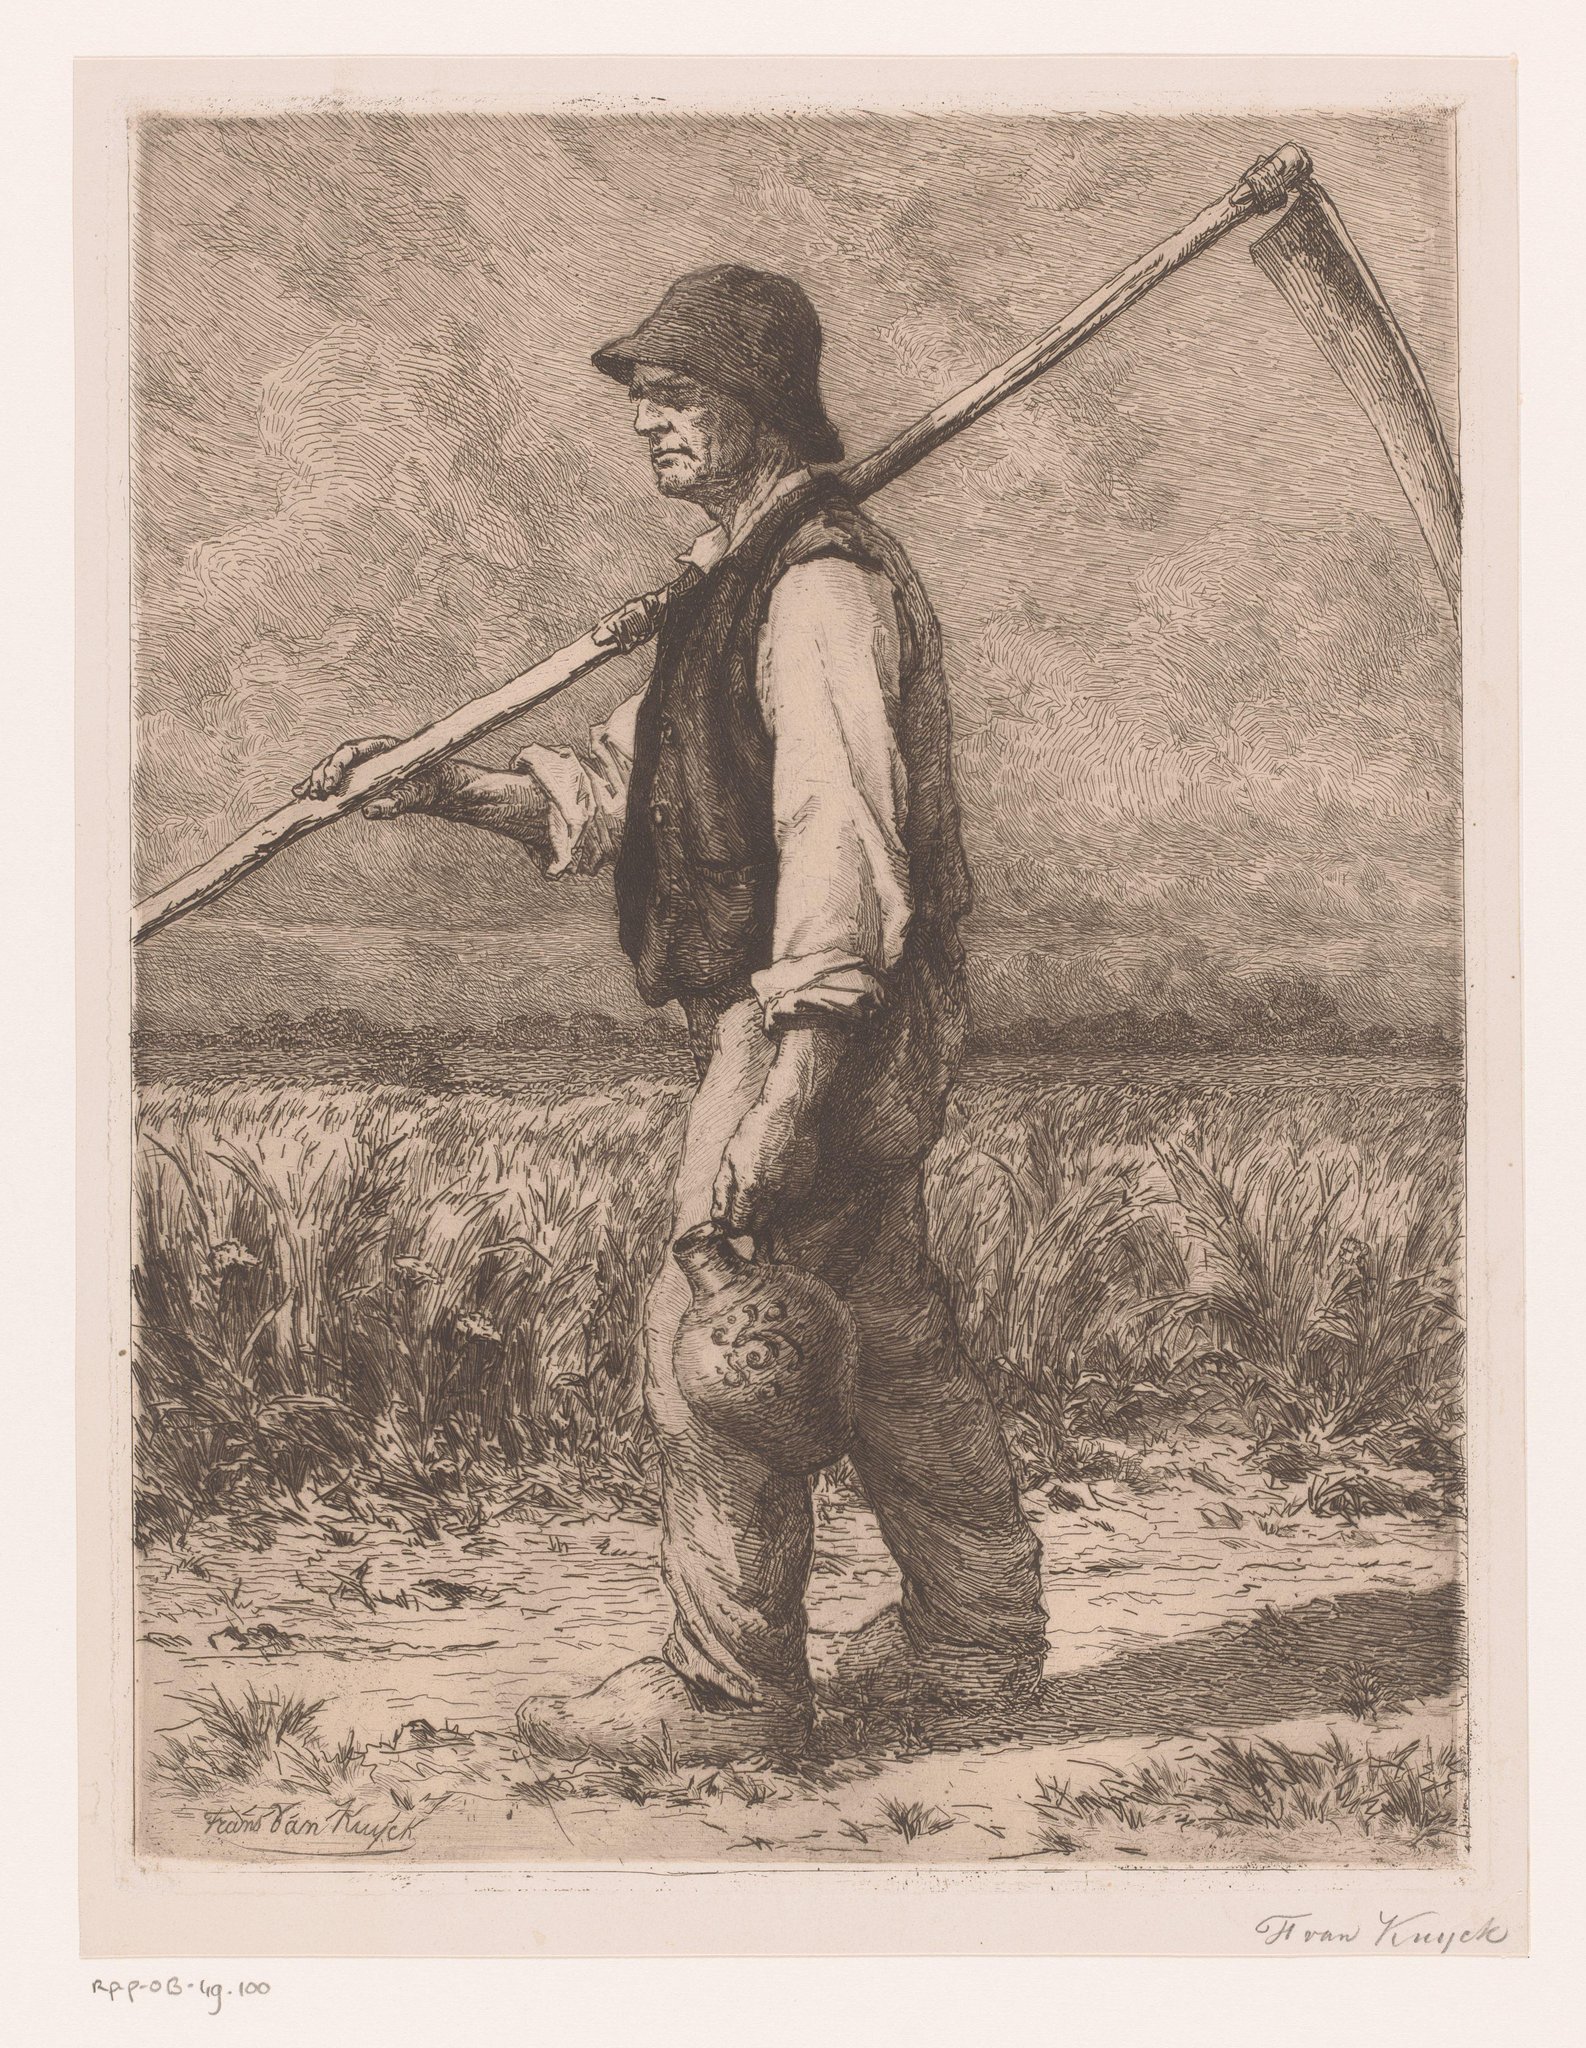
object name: print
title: Boer met zeis en kruik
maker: frans van kuyck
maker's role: painter, print maker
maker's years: 1852-1915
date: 1862-1915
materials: paper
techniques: etching, intaglio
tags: agricultural implements: scythe, container of ceramics: jar, jug, pot, vase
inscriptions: collector's mark: Lugt 2228